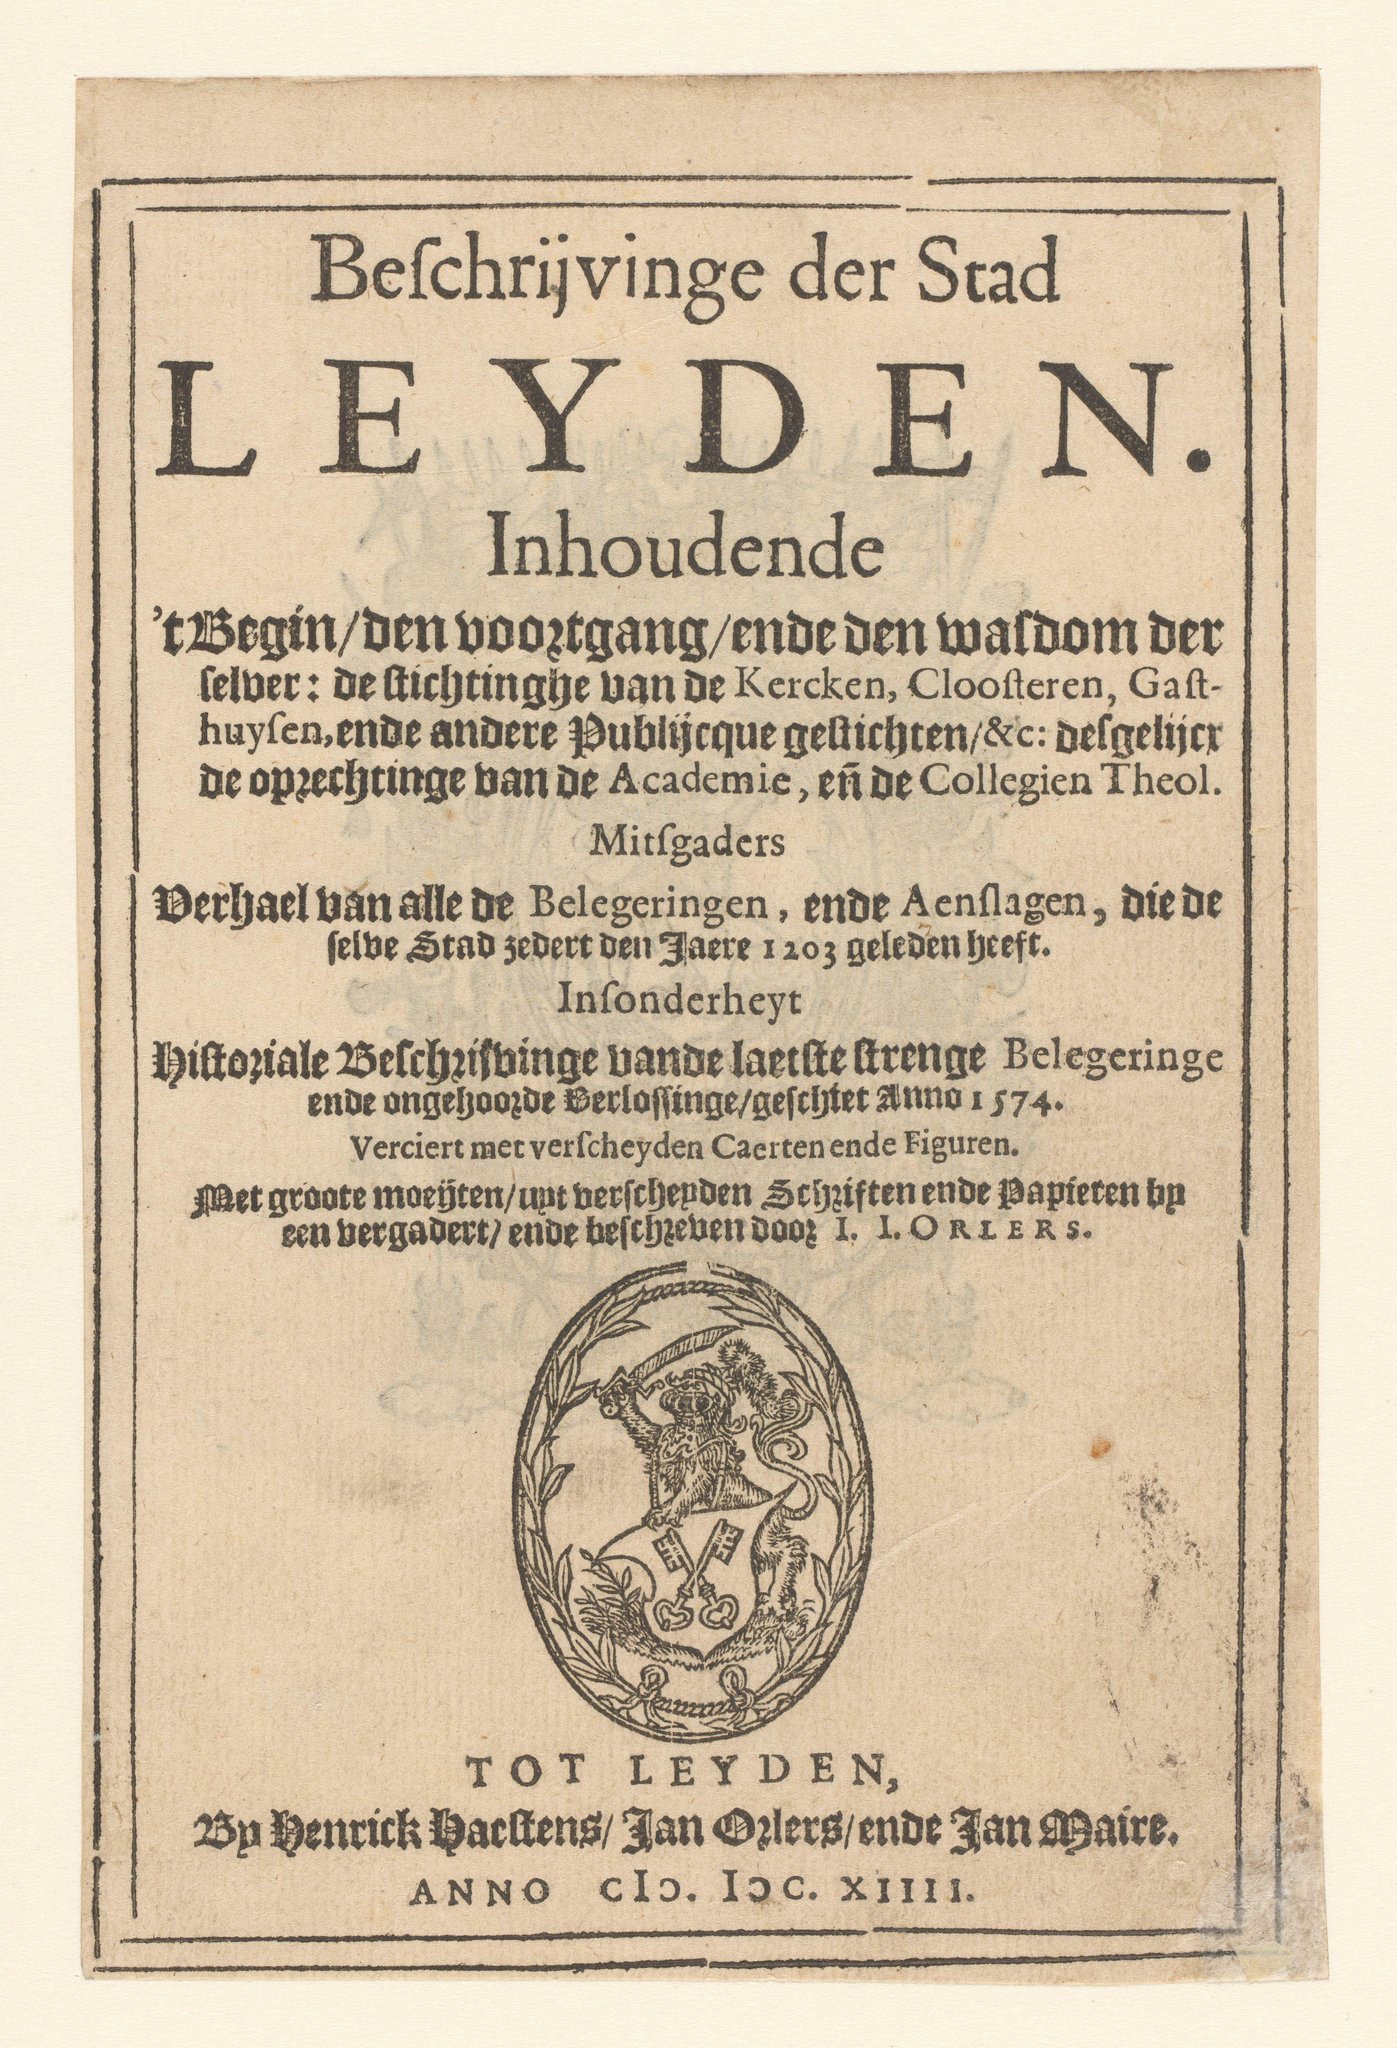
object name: print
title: Titelvignet voor: Jan Jansz Orlers, Beschrĳvinge der stad Leyden, 1614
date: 1614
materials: paper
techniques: letterpress printing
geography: leiden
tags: coat of arms (as symbol of the state, etc.) (+ city; municipal), vignette, leiden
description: Titelvignet voor: Orlers, Jan Jansz. Beschrĳvinge der stad Leyden. Leiden: Henrick Lodewijcxsoon van Haestens, Jan Jansz. Orlers en Joannes Maire, 1614.